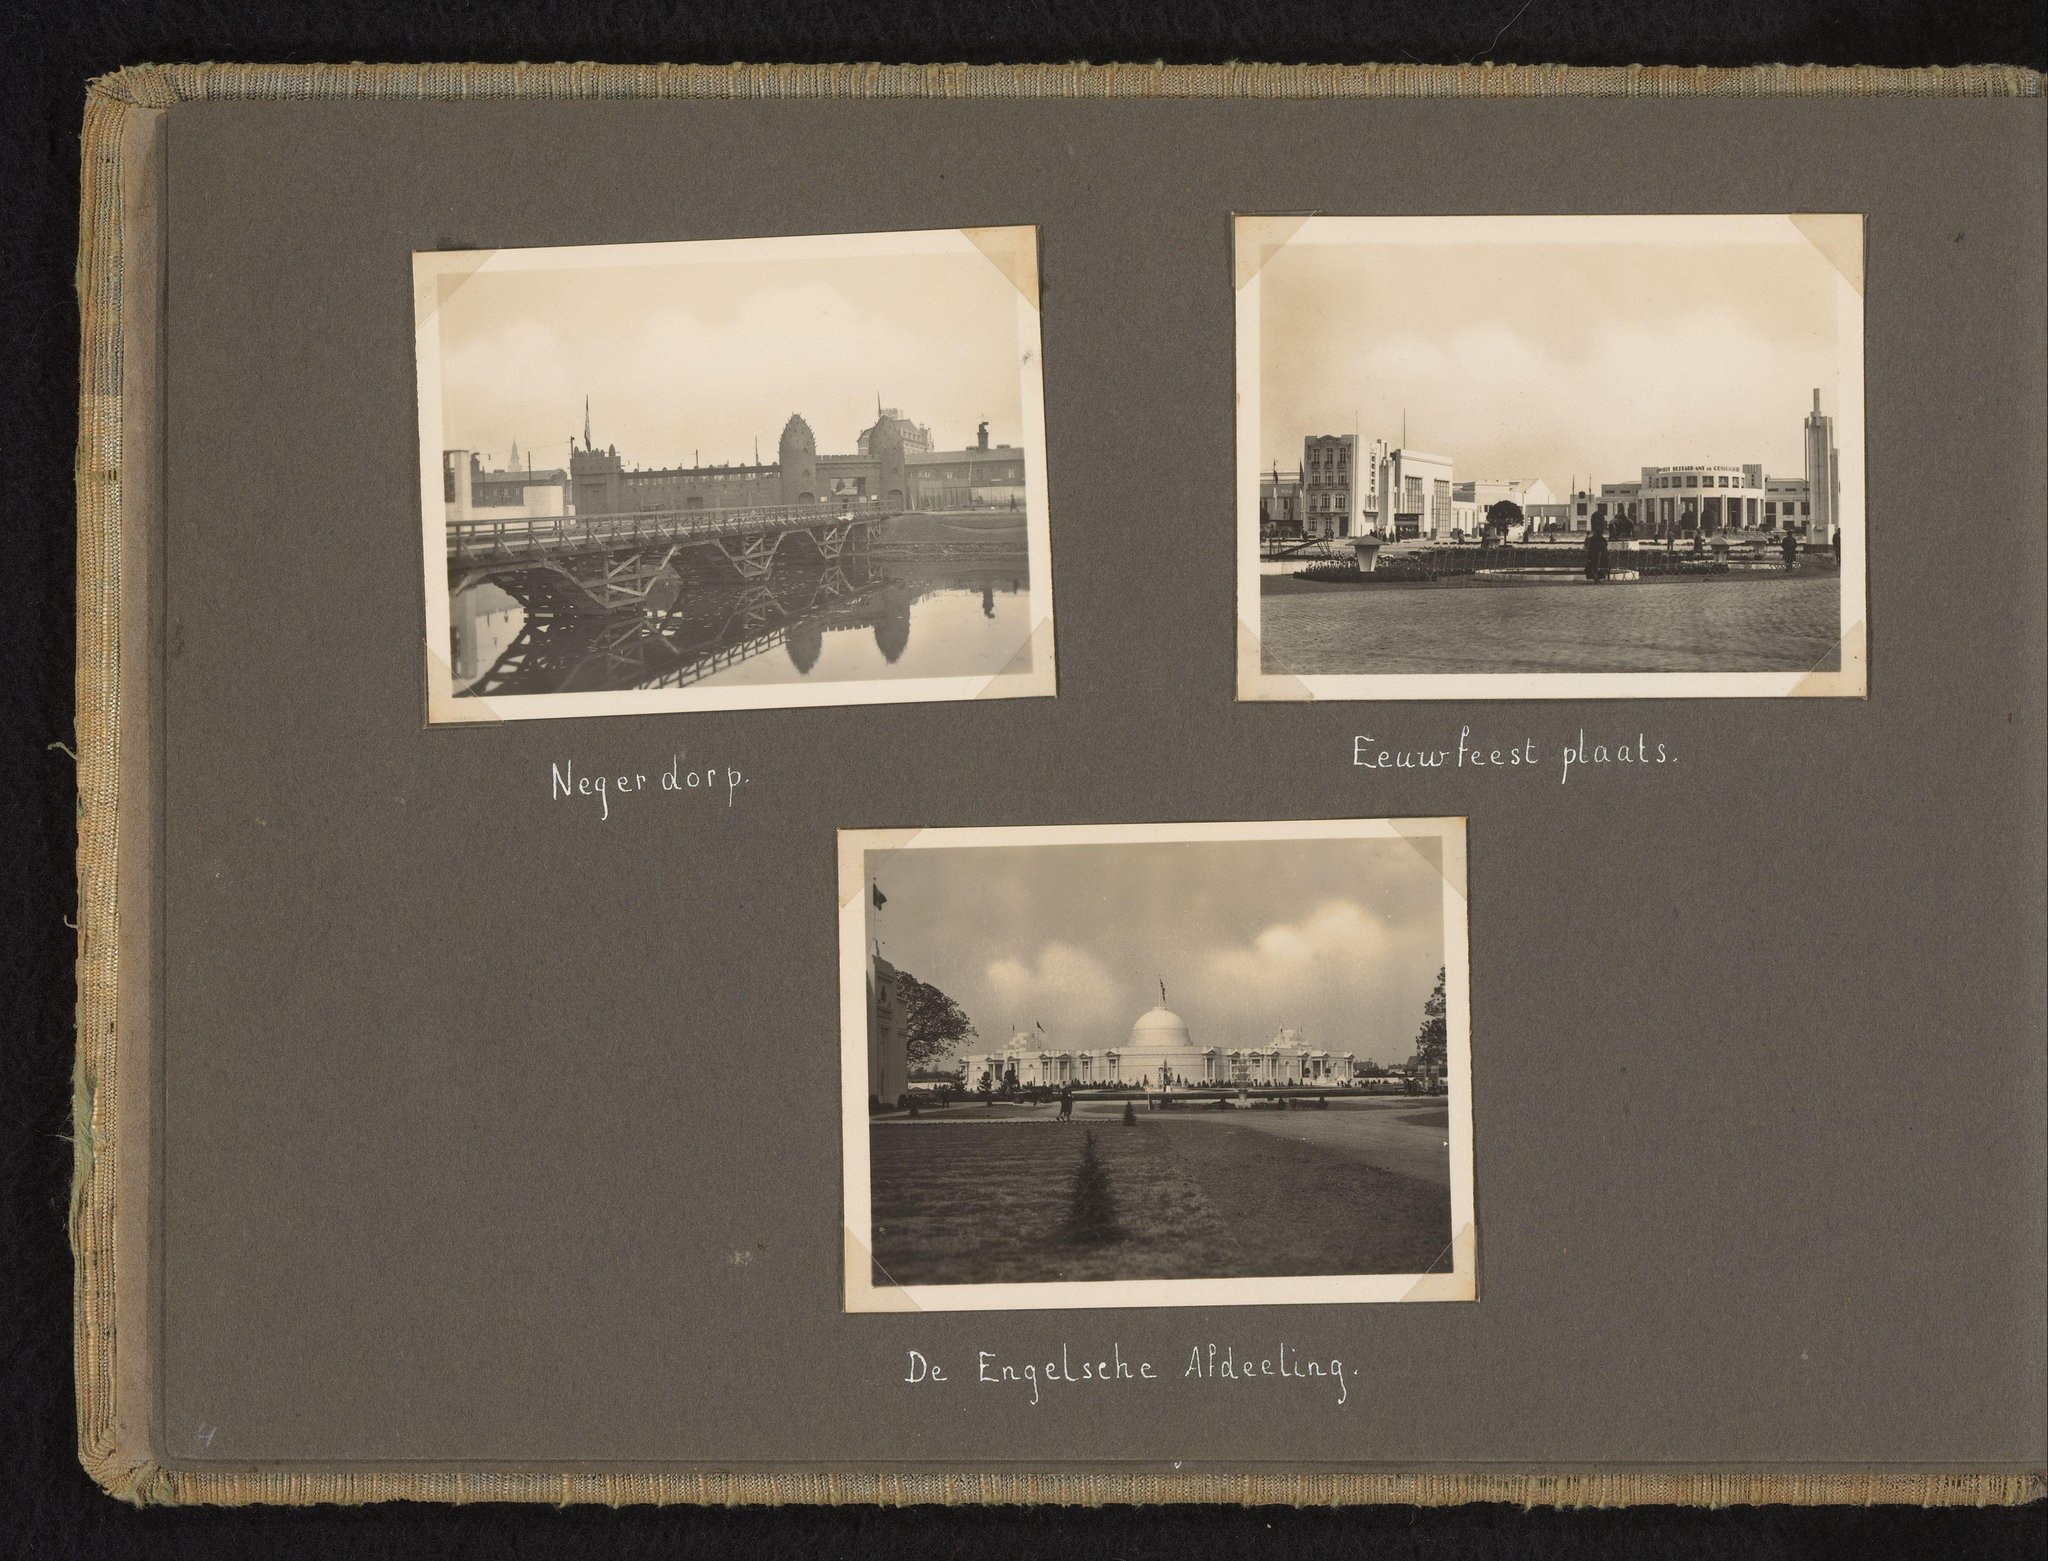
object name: album leaf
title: Bezoek aan de Wereldtentoonstelling te Antwerpen, oktober 1930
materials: cardboard, photographic support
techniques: gelatin silver print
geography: antwerp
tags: world fair, world exhibition, outing, pleasure trip, student life, antwerp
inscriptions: inscription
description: Albumblad met drie foto's van een bezoek aan verschillende paviljoens op de Wereldtentoonstelling te Antwerpen in 1930. Onderdeel van fotoalbum 'Studentenalbum Indologen'.